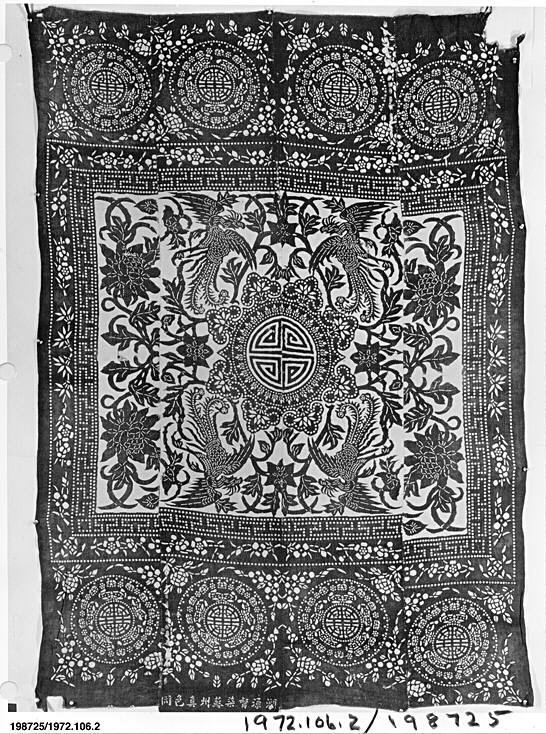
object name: panel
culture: chinese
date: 1801-1900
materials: cotton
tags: flowers